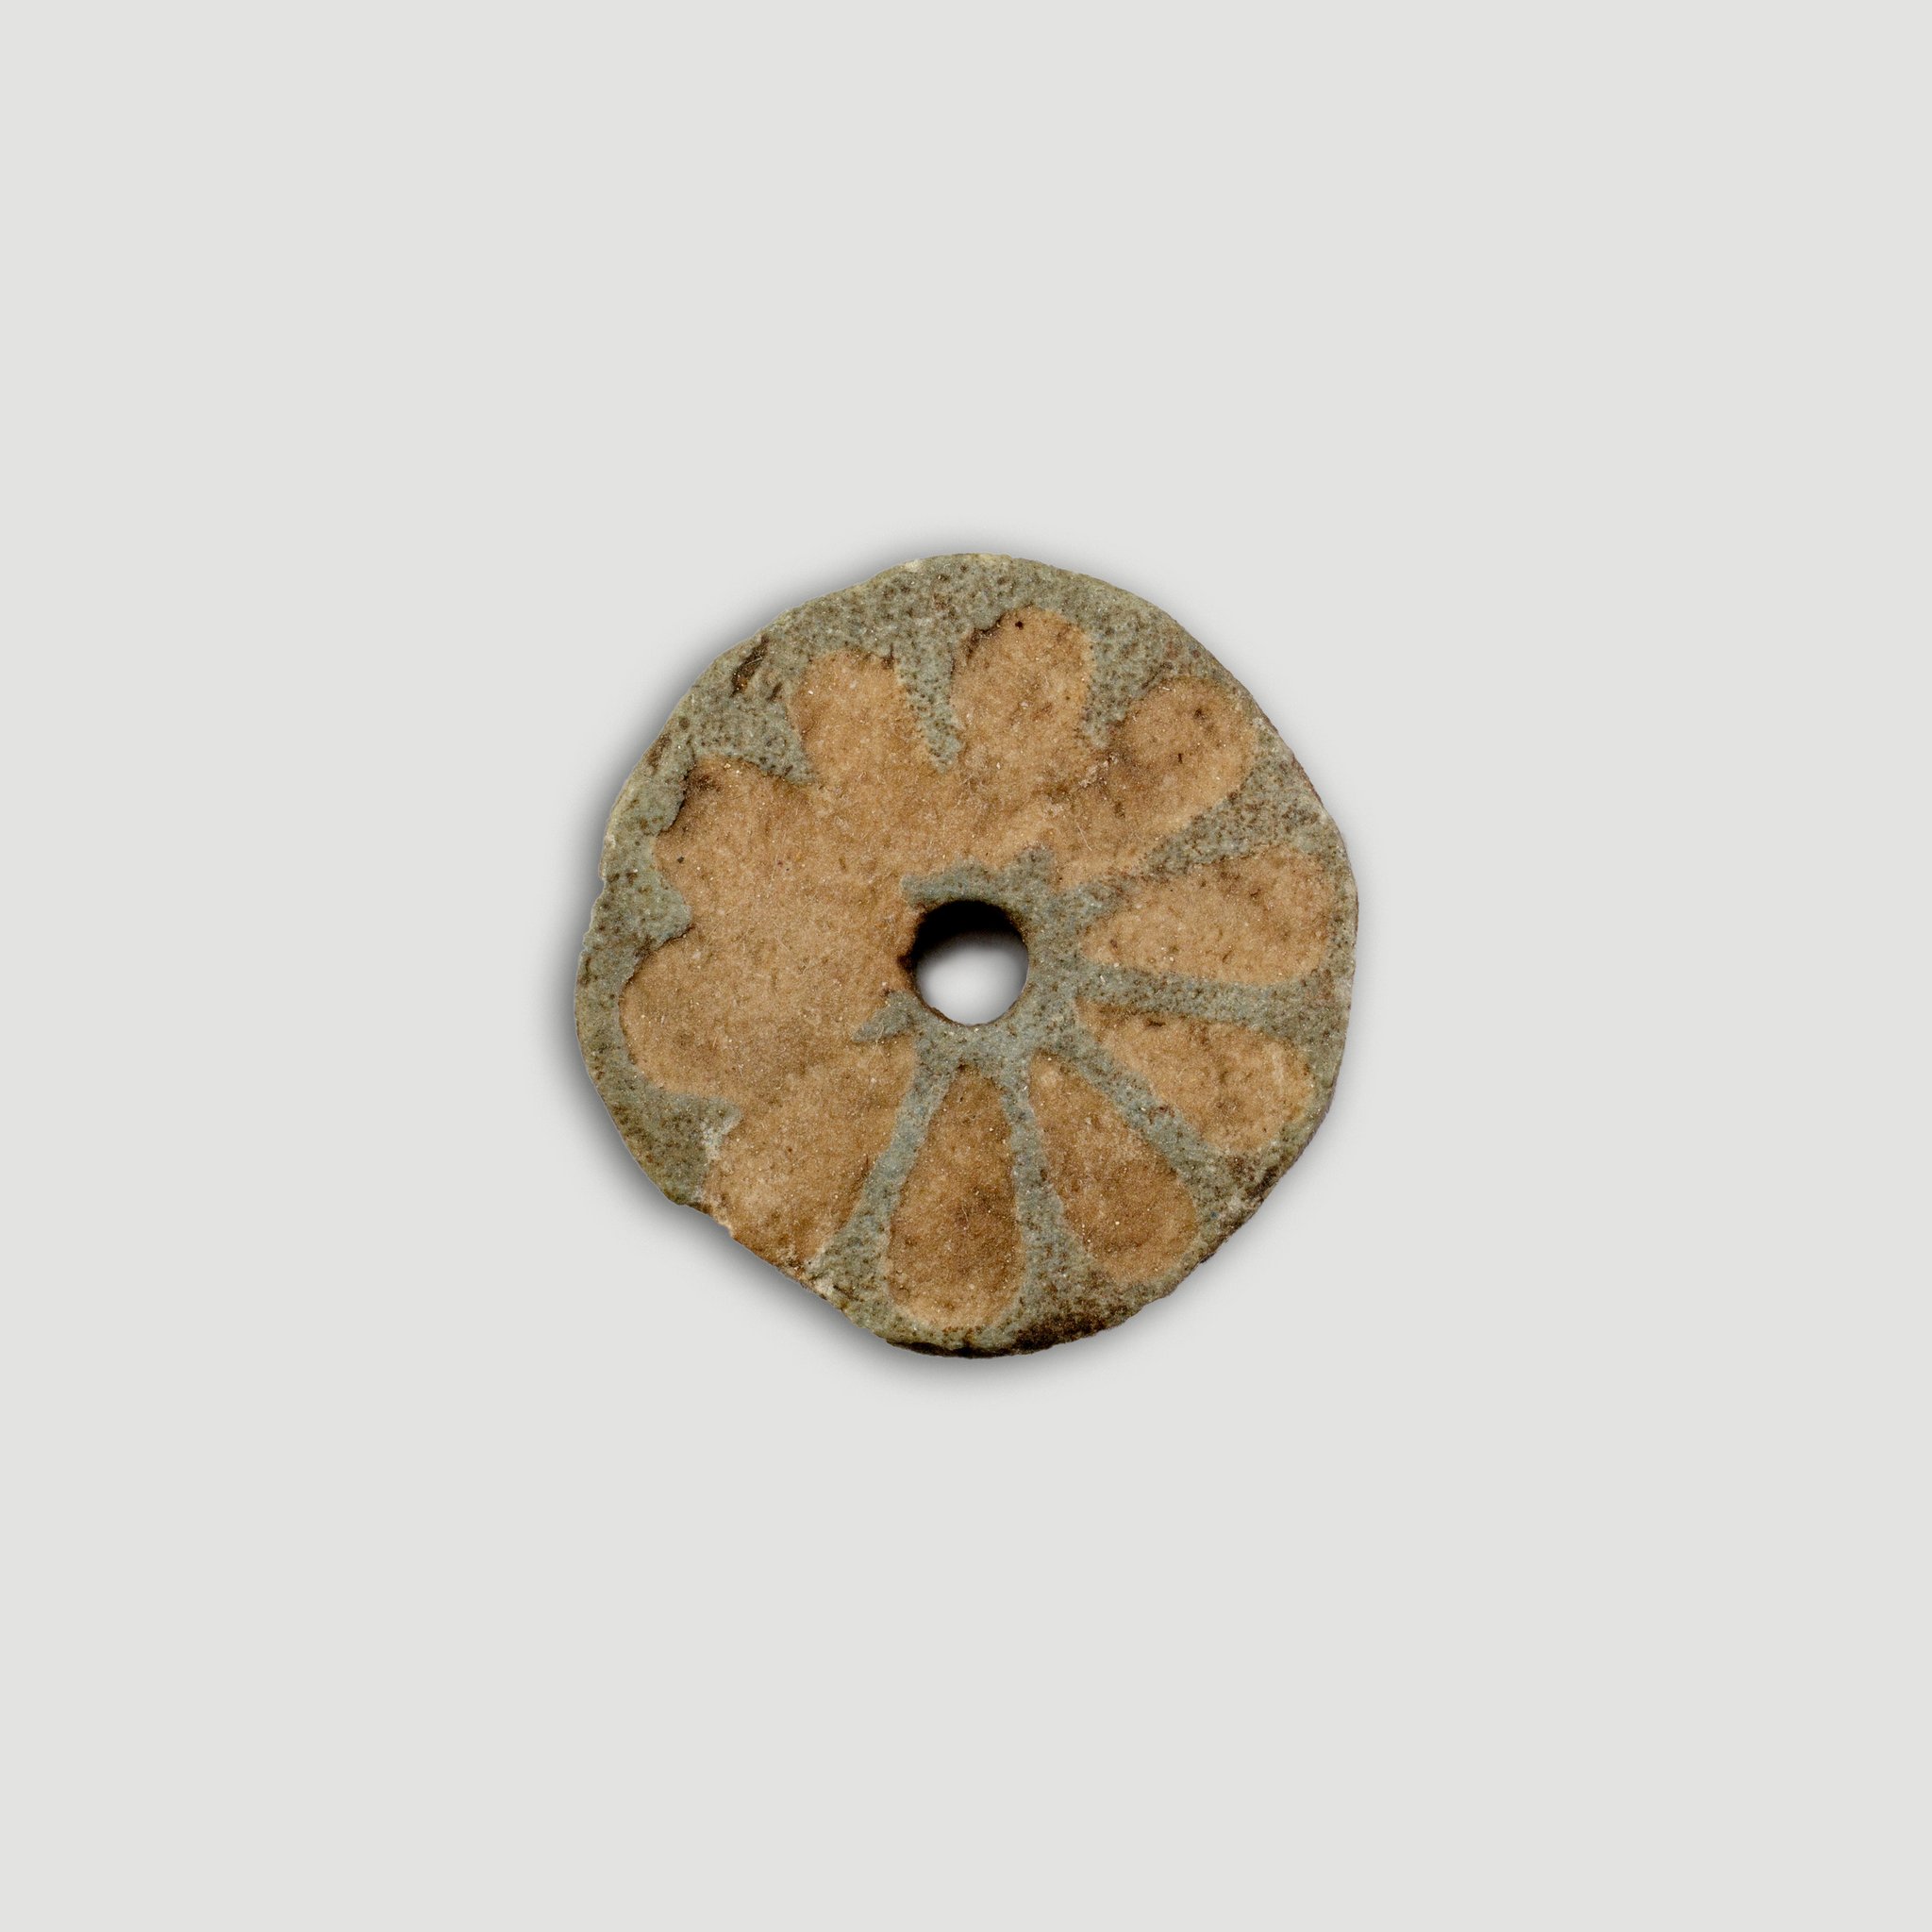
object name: tile, palace of ramesses ii, rosette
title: Tiles and ornaments from the palace of Ramesses II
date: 1279-1213 BCE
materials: faience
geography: egypt